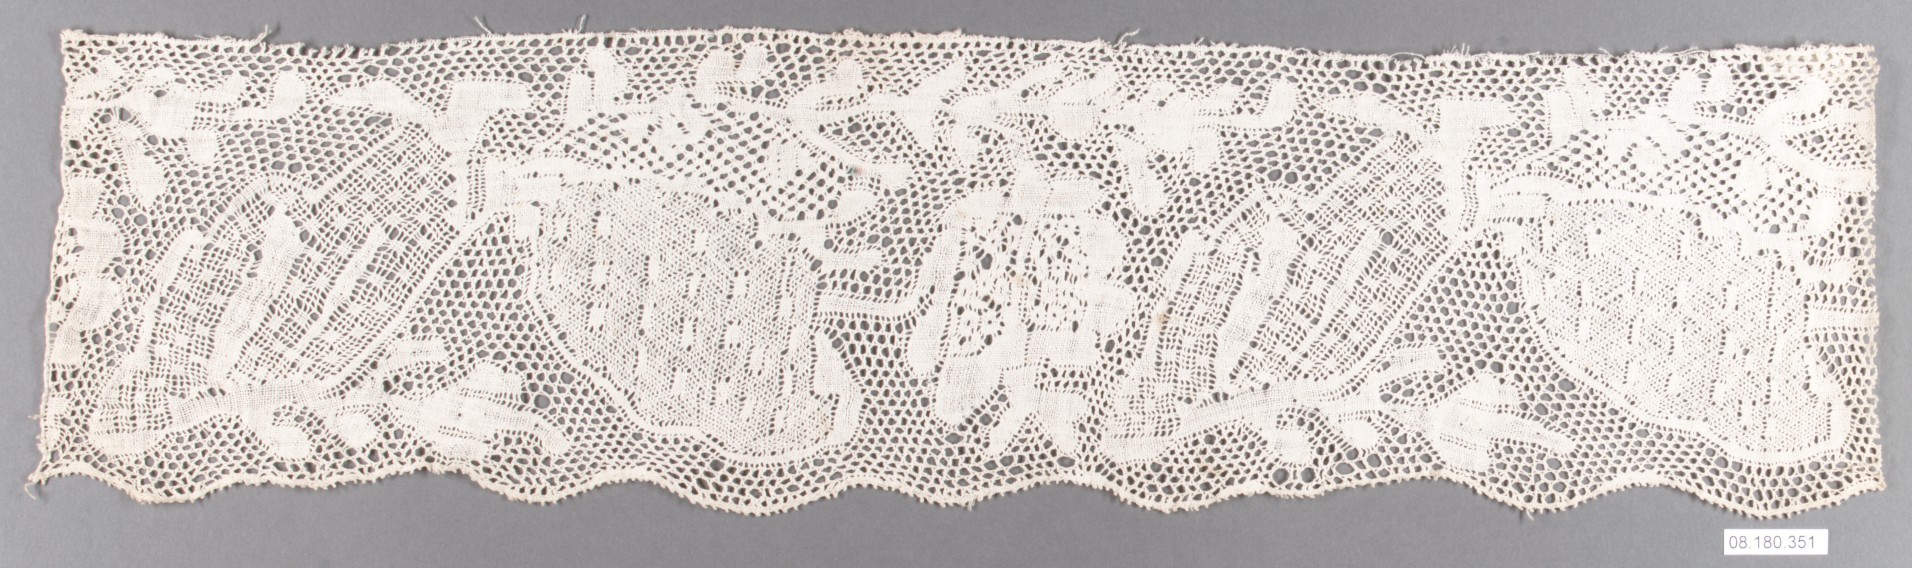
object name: piece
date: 1701-1800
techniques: lace